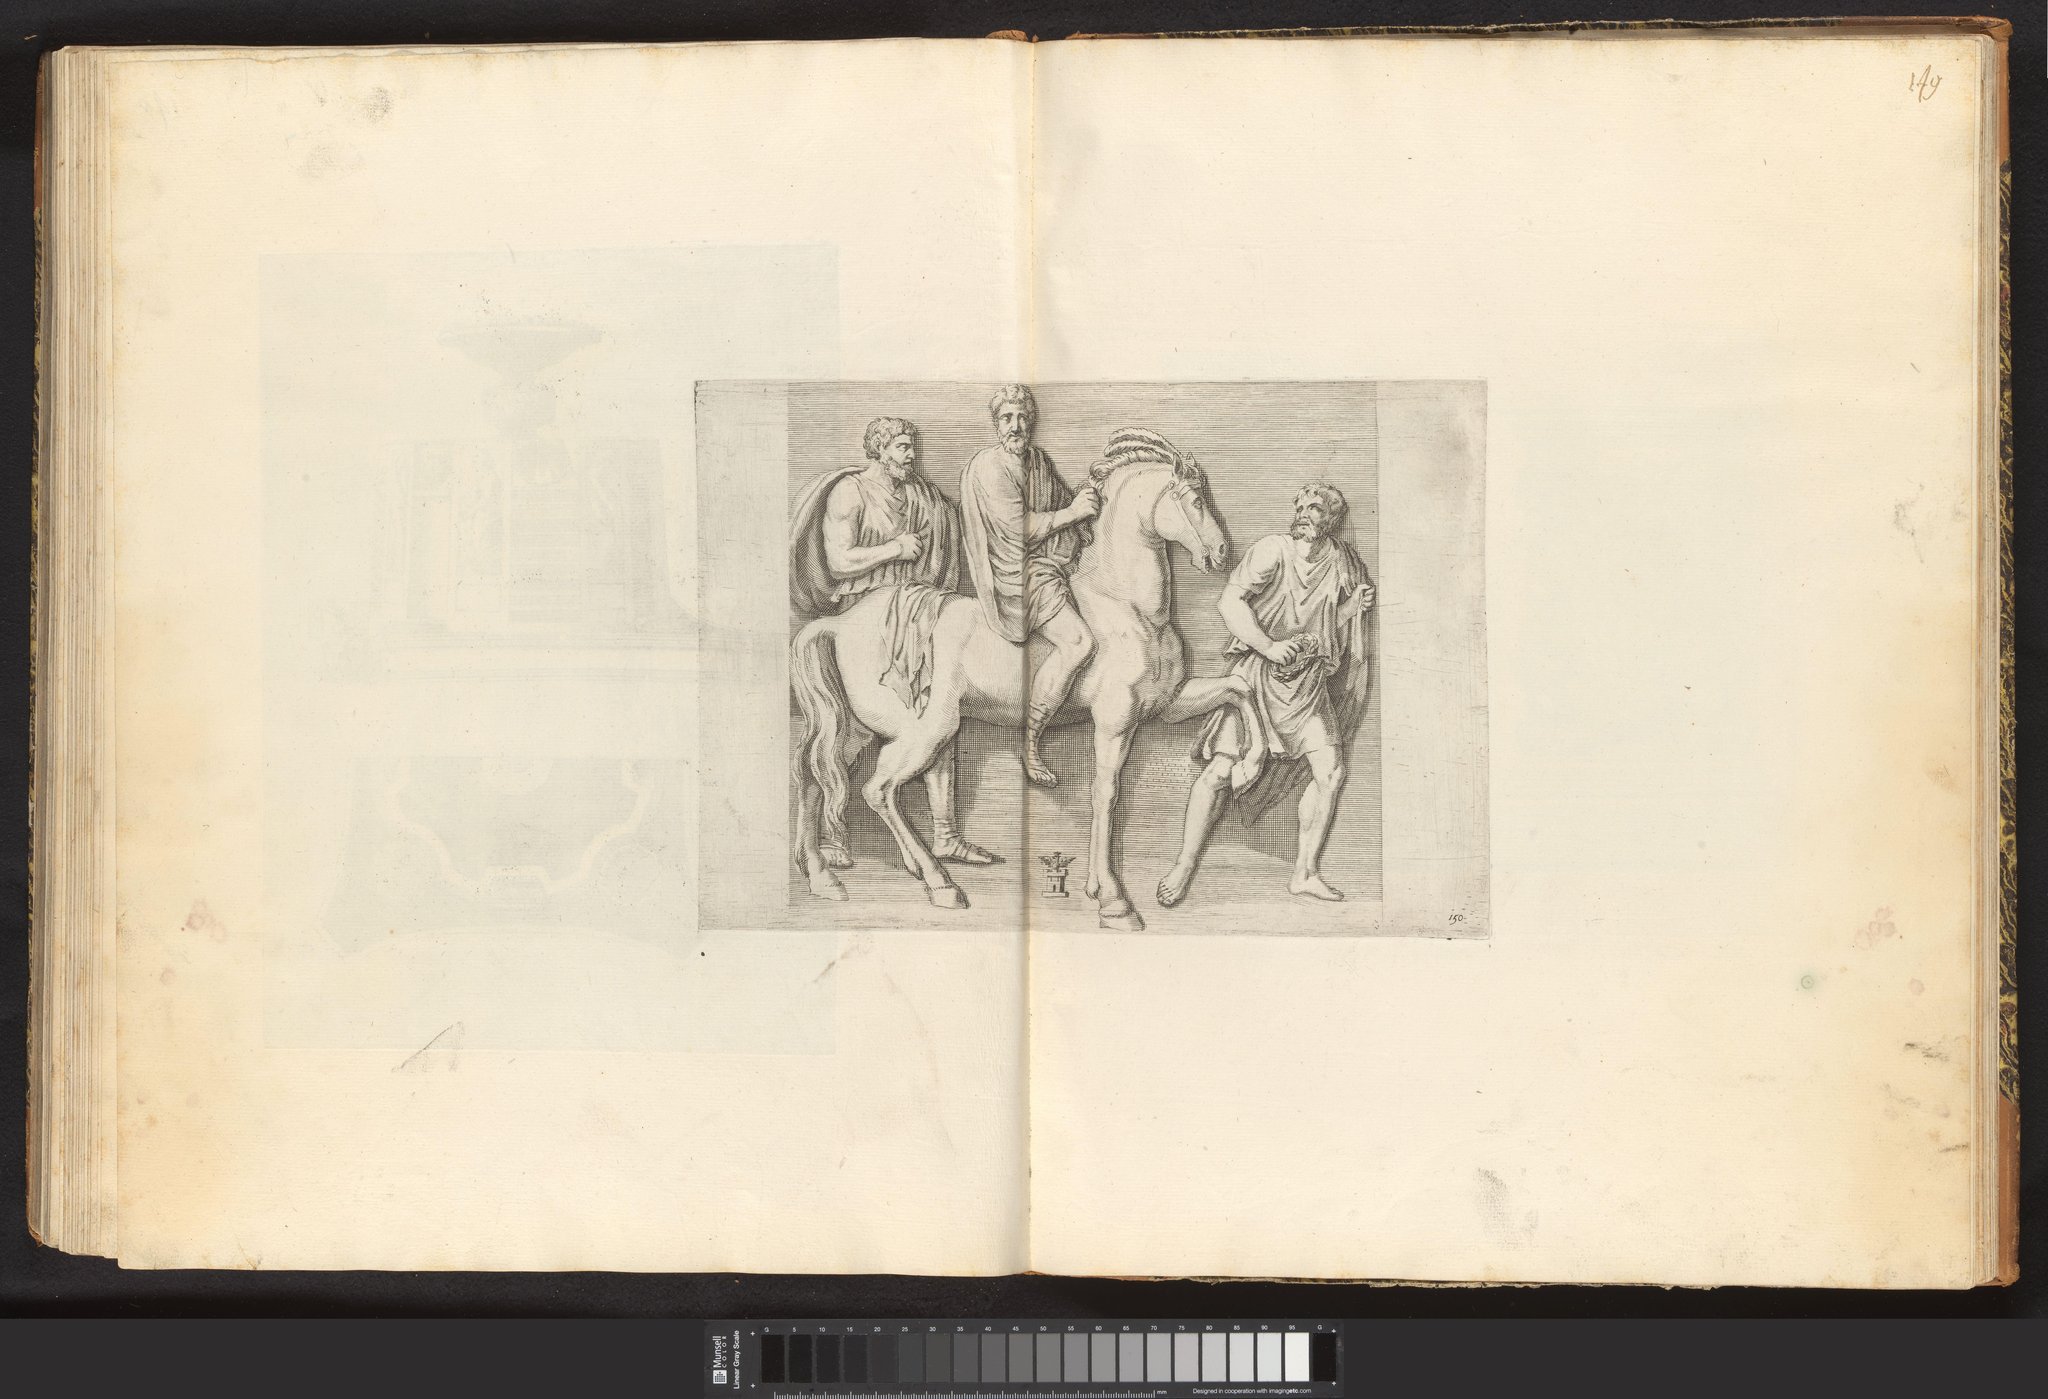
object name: print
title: Poort naar de tuin van Vincenzo Giustiniani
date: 1636-1647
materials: paper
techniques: engraving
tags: gate, entrance, piece of sculpture, reproduction of a piece of sculpture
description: Poort naar de tuin van Vincenzo Giustiniani. Boven de poort het wapenschild van Vincenzo Giustiniani. Prent maakt deel uit van een album met een serie prenten naar de sculpturen in de verzameling in de Galleria Giustiniani te Rome.